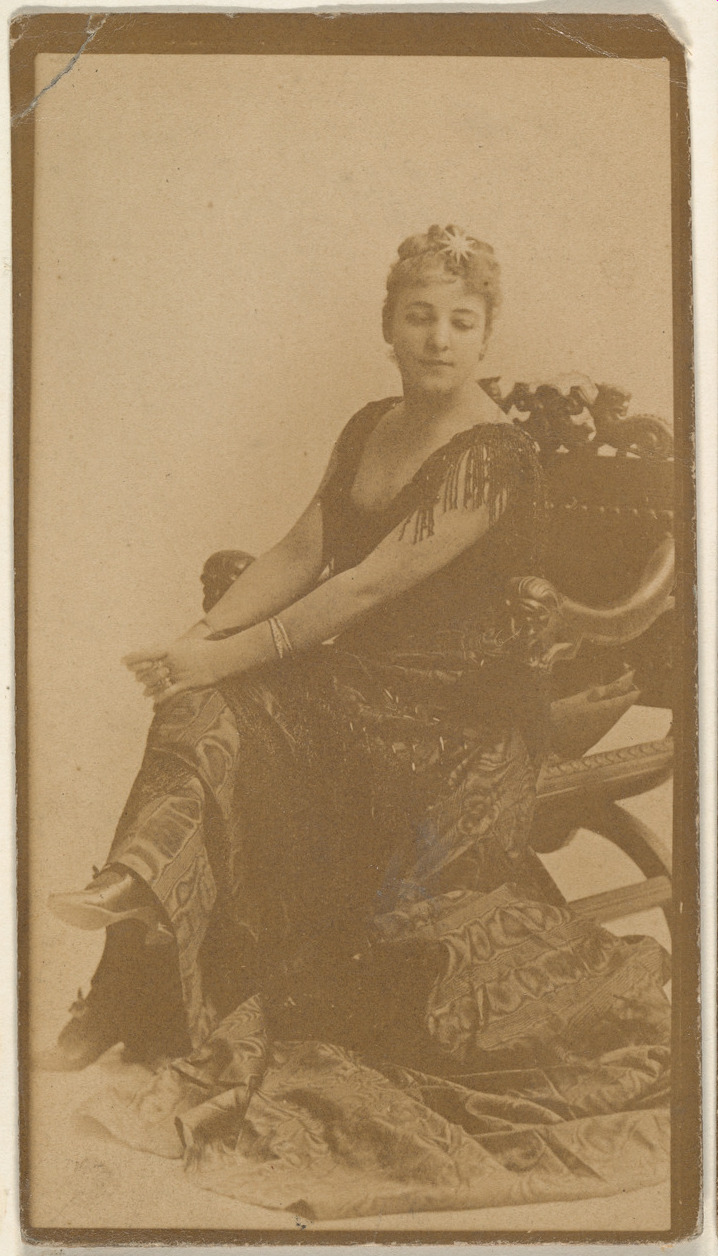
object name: photograph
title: Seated actress with hands resting on knees, from the Actresses series (N668)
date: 1888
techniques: albumen silver print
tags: portraits,women,actresses